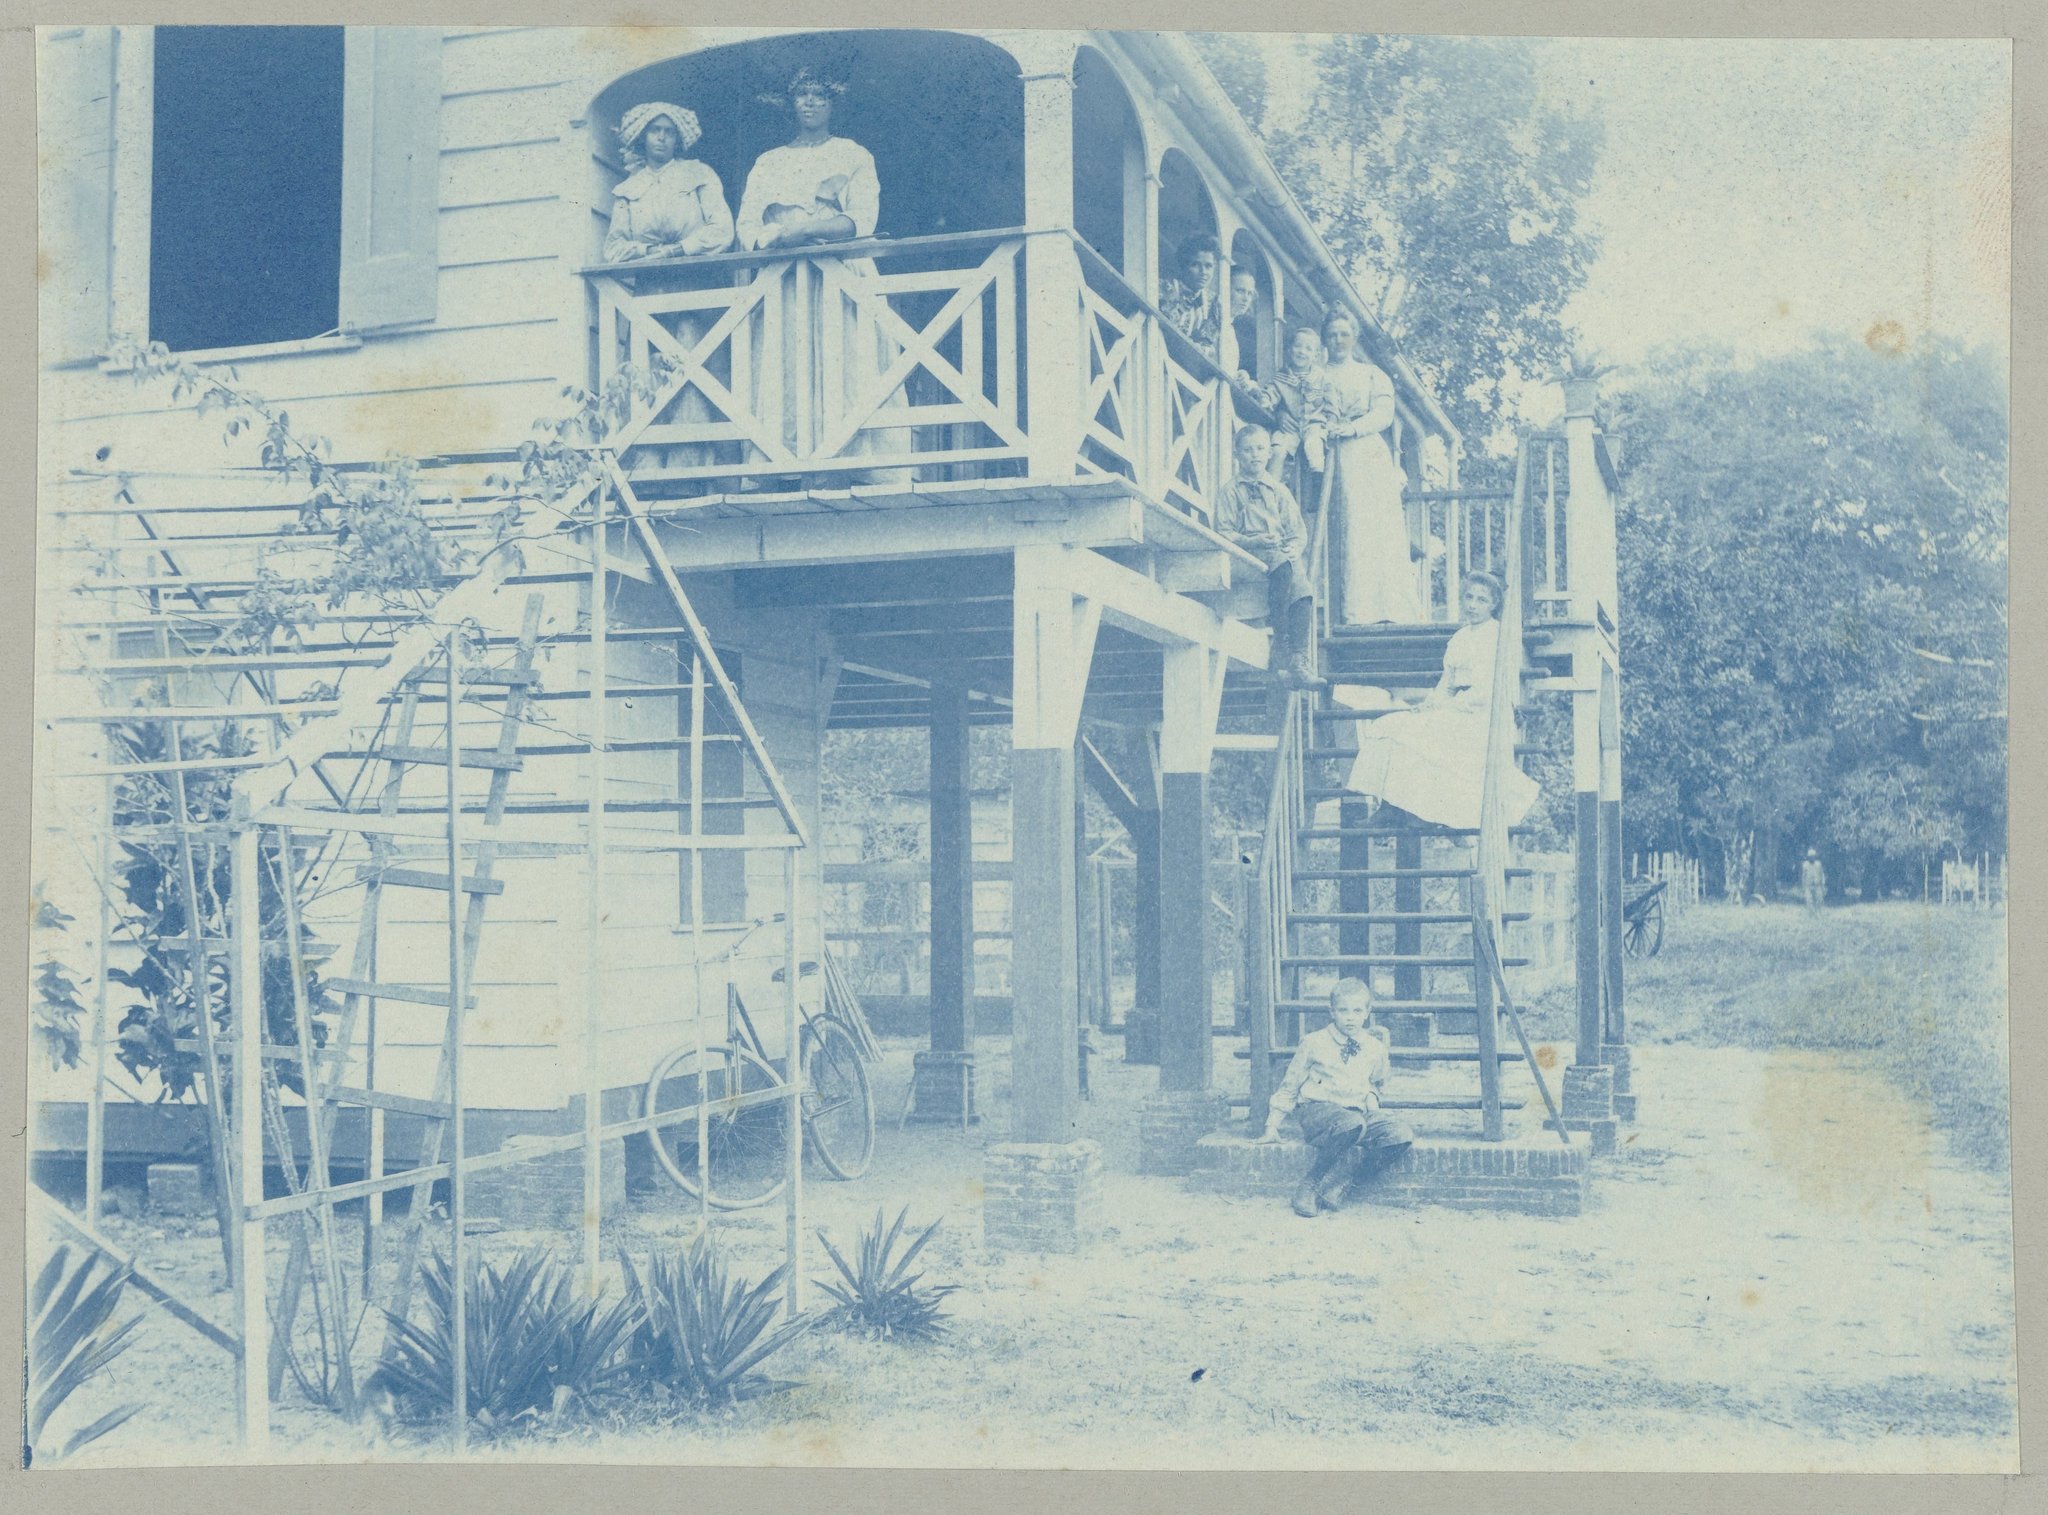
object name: photograph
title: Tourtonne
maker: hendrik doijer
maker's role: engineer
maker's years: 1863-1925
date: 1903-1910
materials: photographic support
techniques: cyanotype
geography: suriname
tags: suriname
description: Het huis bij de plantage Tourtonne. Op de trap en balkon staat een Europees gezin en enkele Surinaamse vrouwen. Onderdeel van het fotoalbum Souvenir de Voyage (deel 2), over het leven van de familie Doijer in en rond de plantage Ma Retraite in Suriname in de jaren 1903-1910.